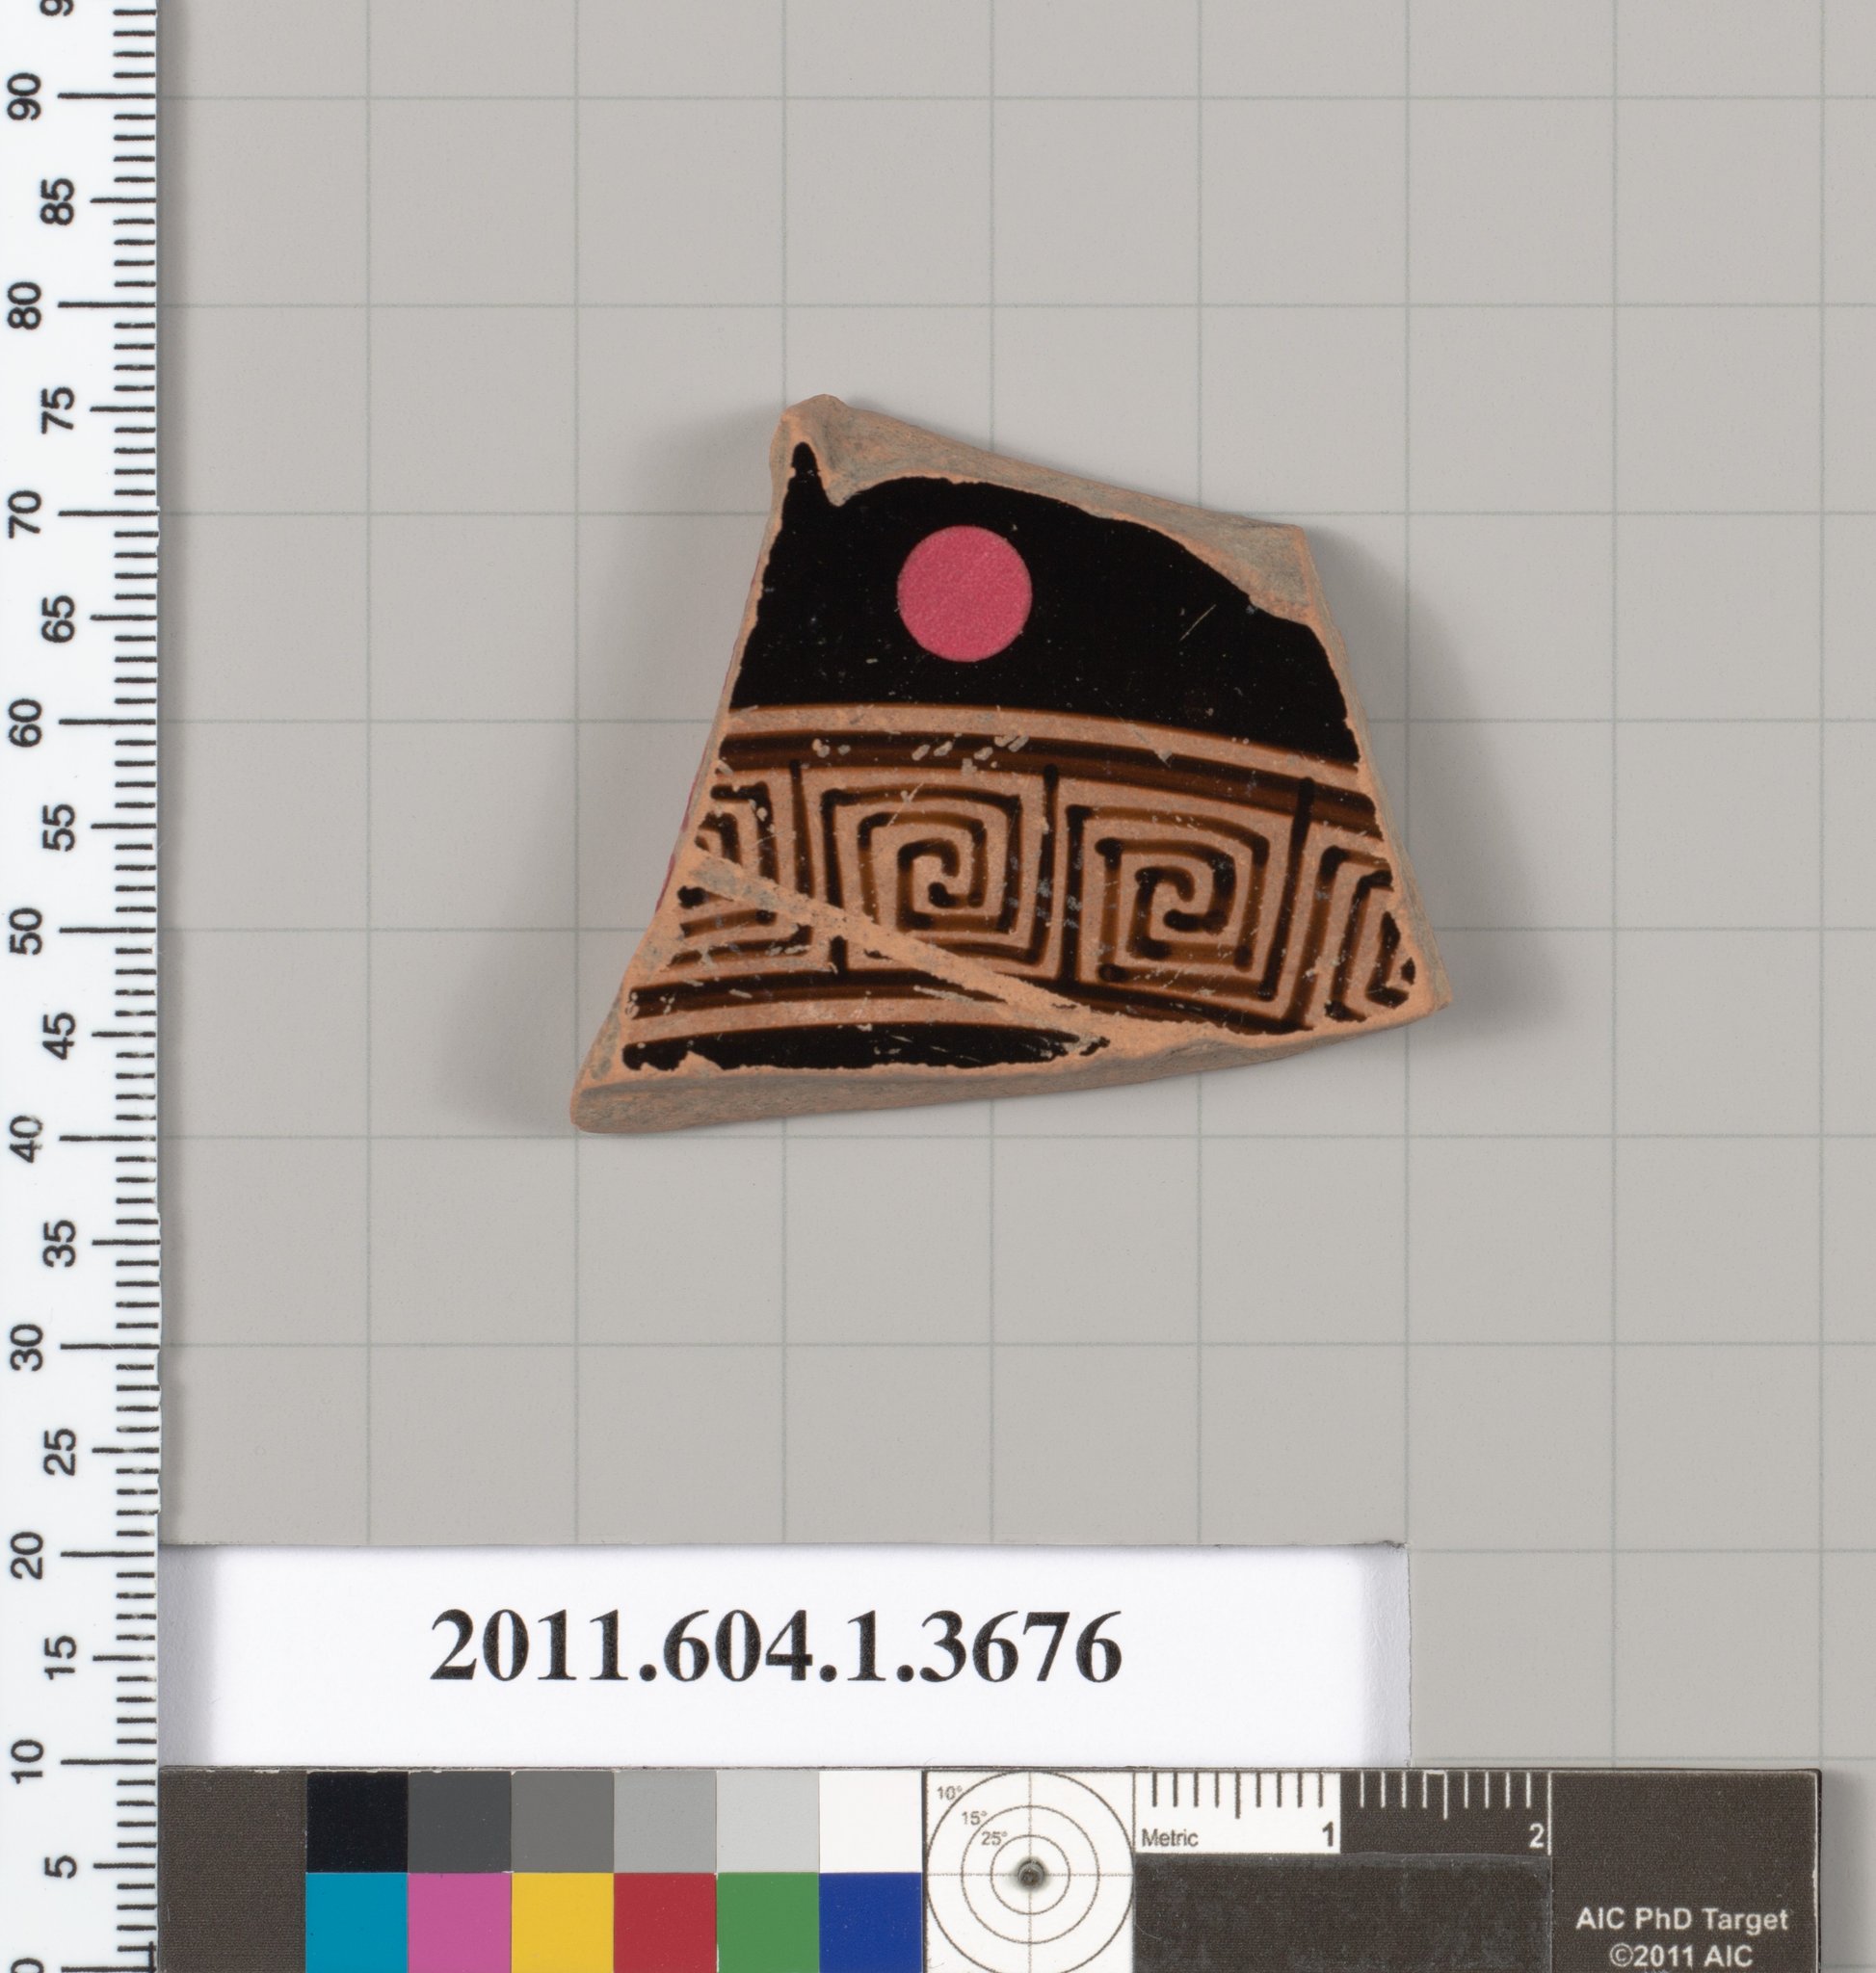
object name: kylix fragment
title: Terracotta fragment of a kylix (drinking cup)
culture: greek, attic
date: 475-451 BCE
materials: terracotta